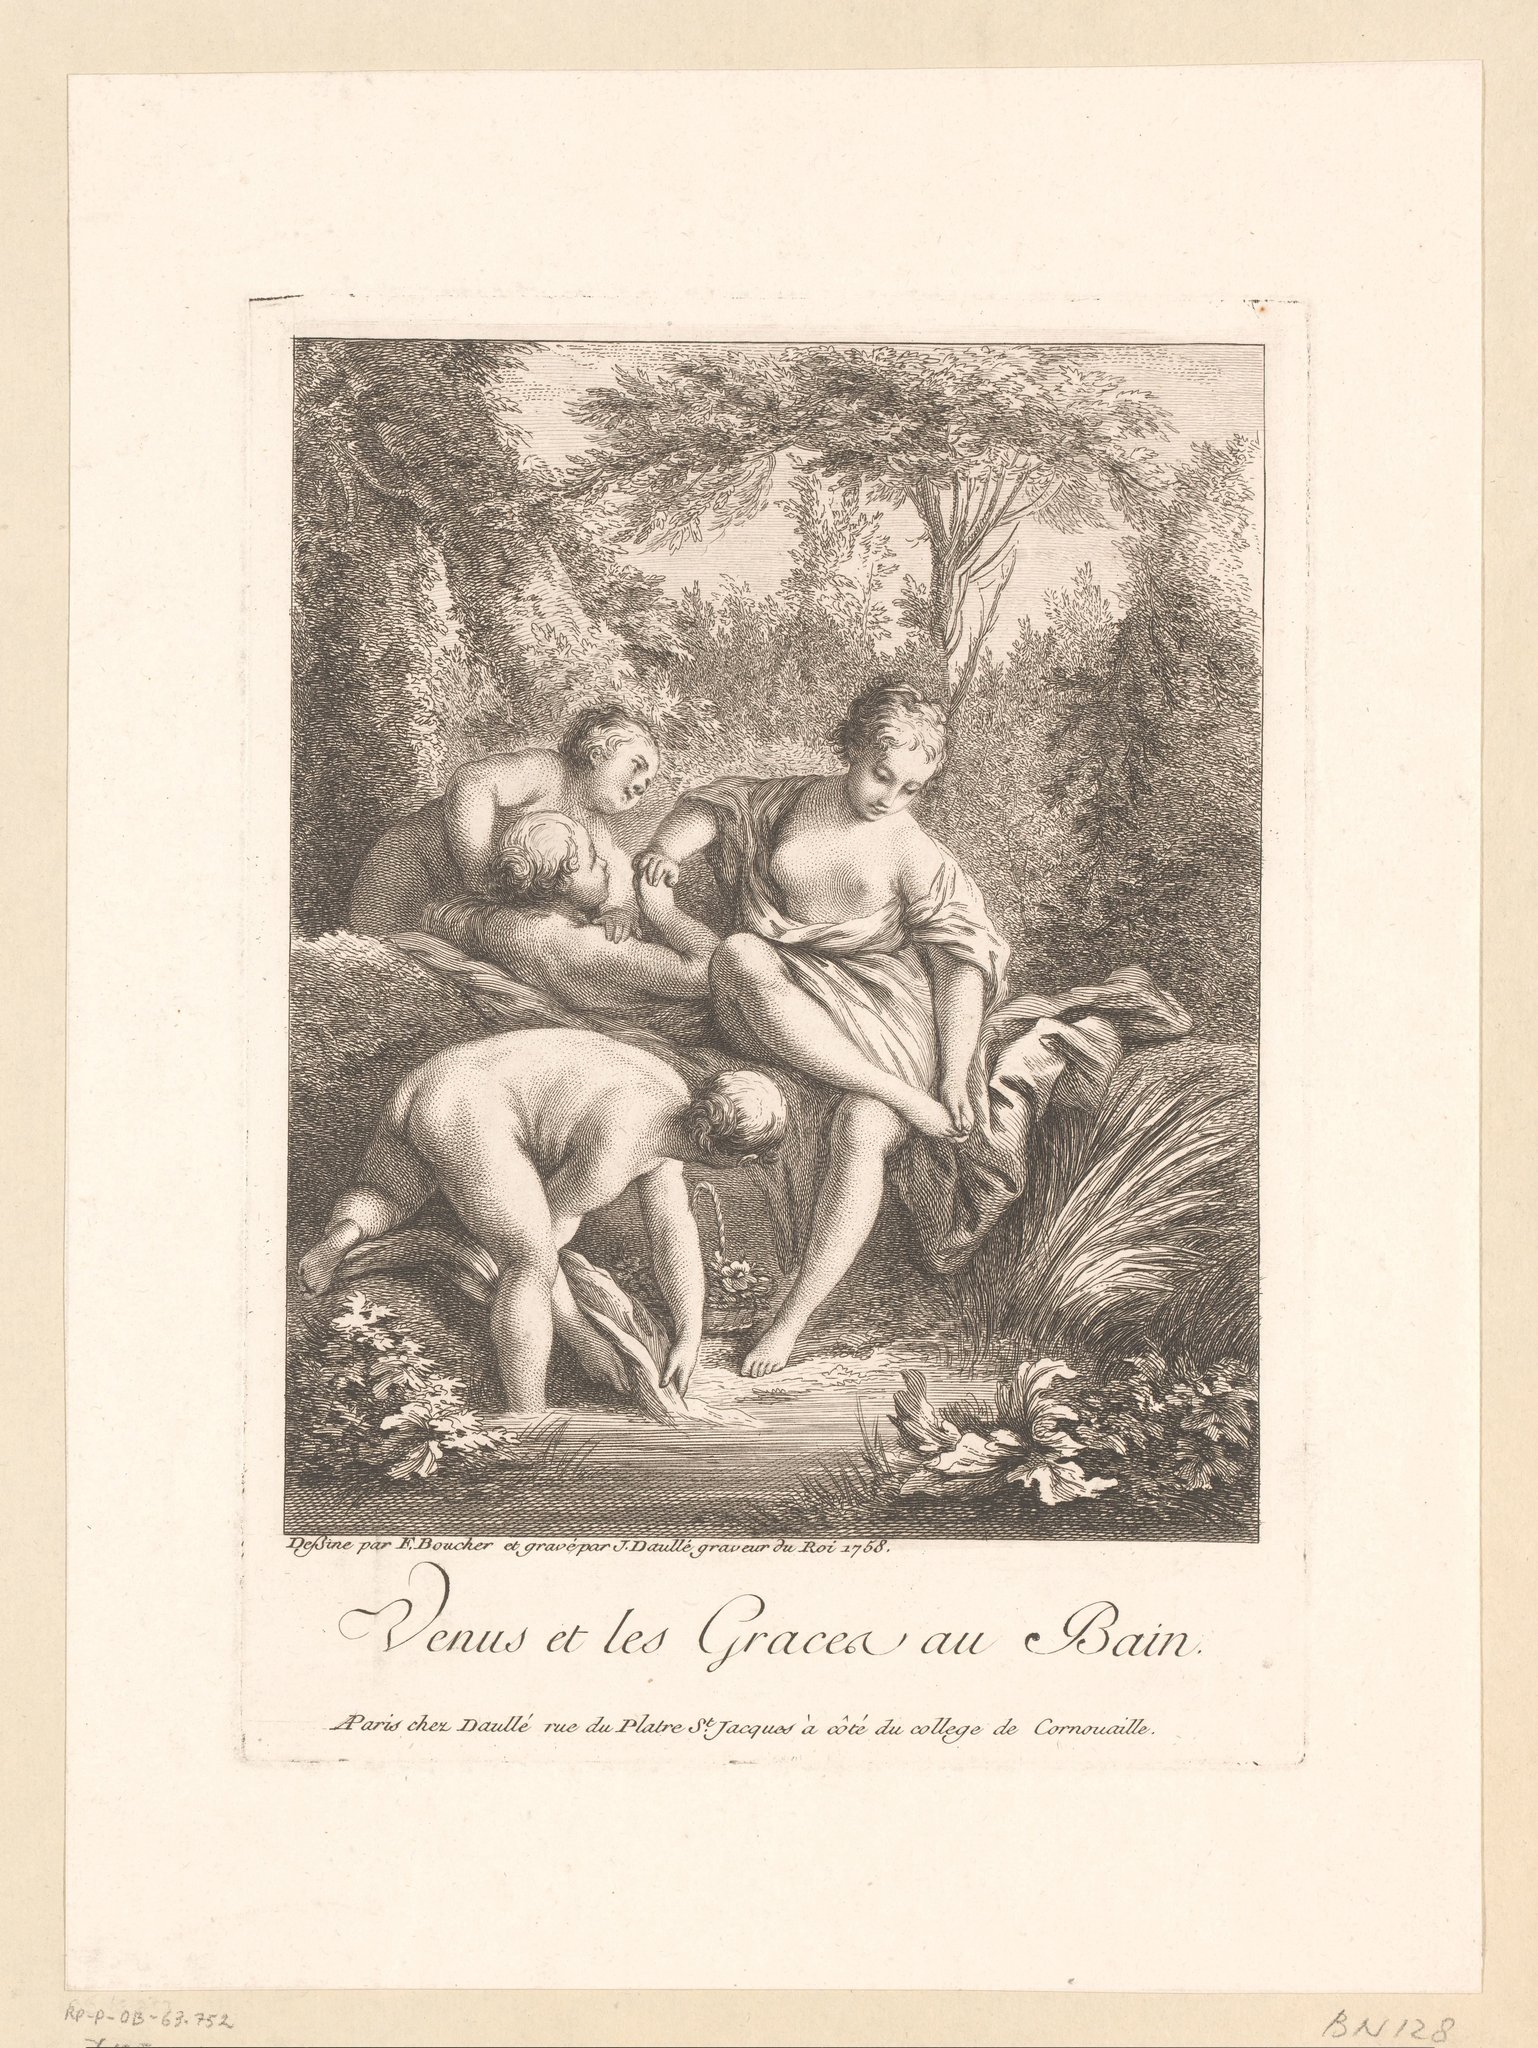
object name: print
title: Venus et les Graces au Bain.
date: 1758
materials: paper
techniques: engraving, etching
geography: paris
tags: bath of venus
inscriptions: collector's mark: Lugt 240